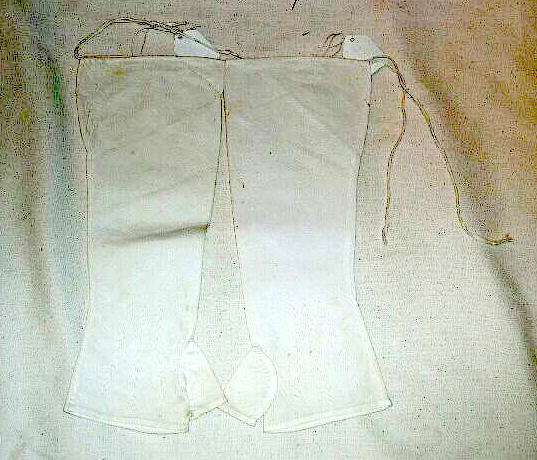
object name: mitt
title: Mitts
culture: american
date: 1838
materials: linen